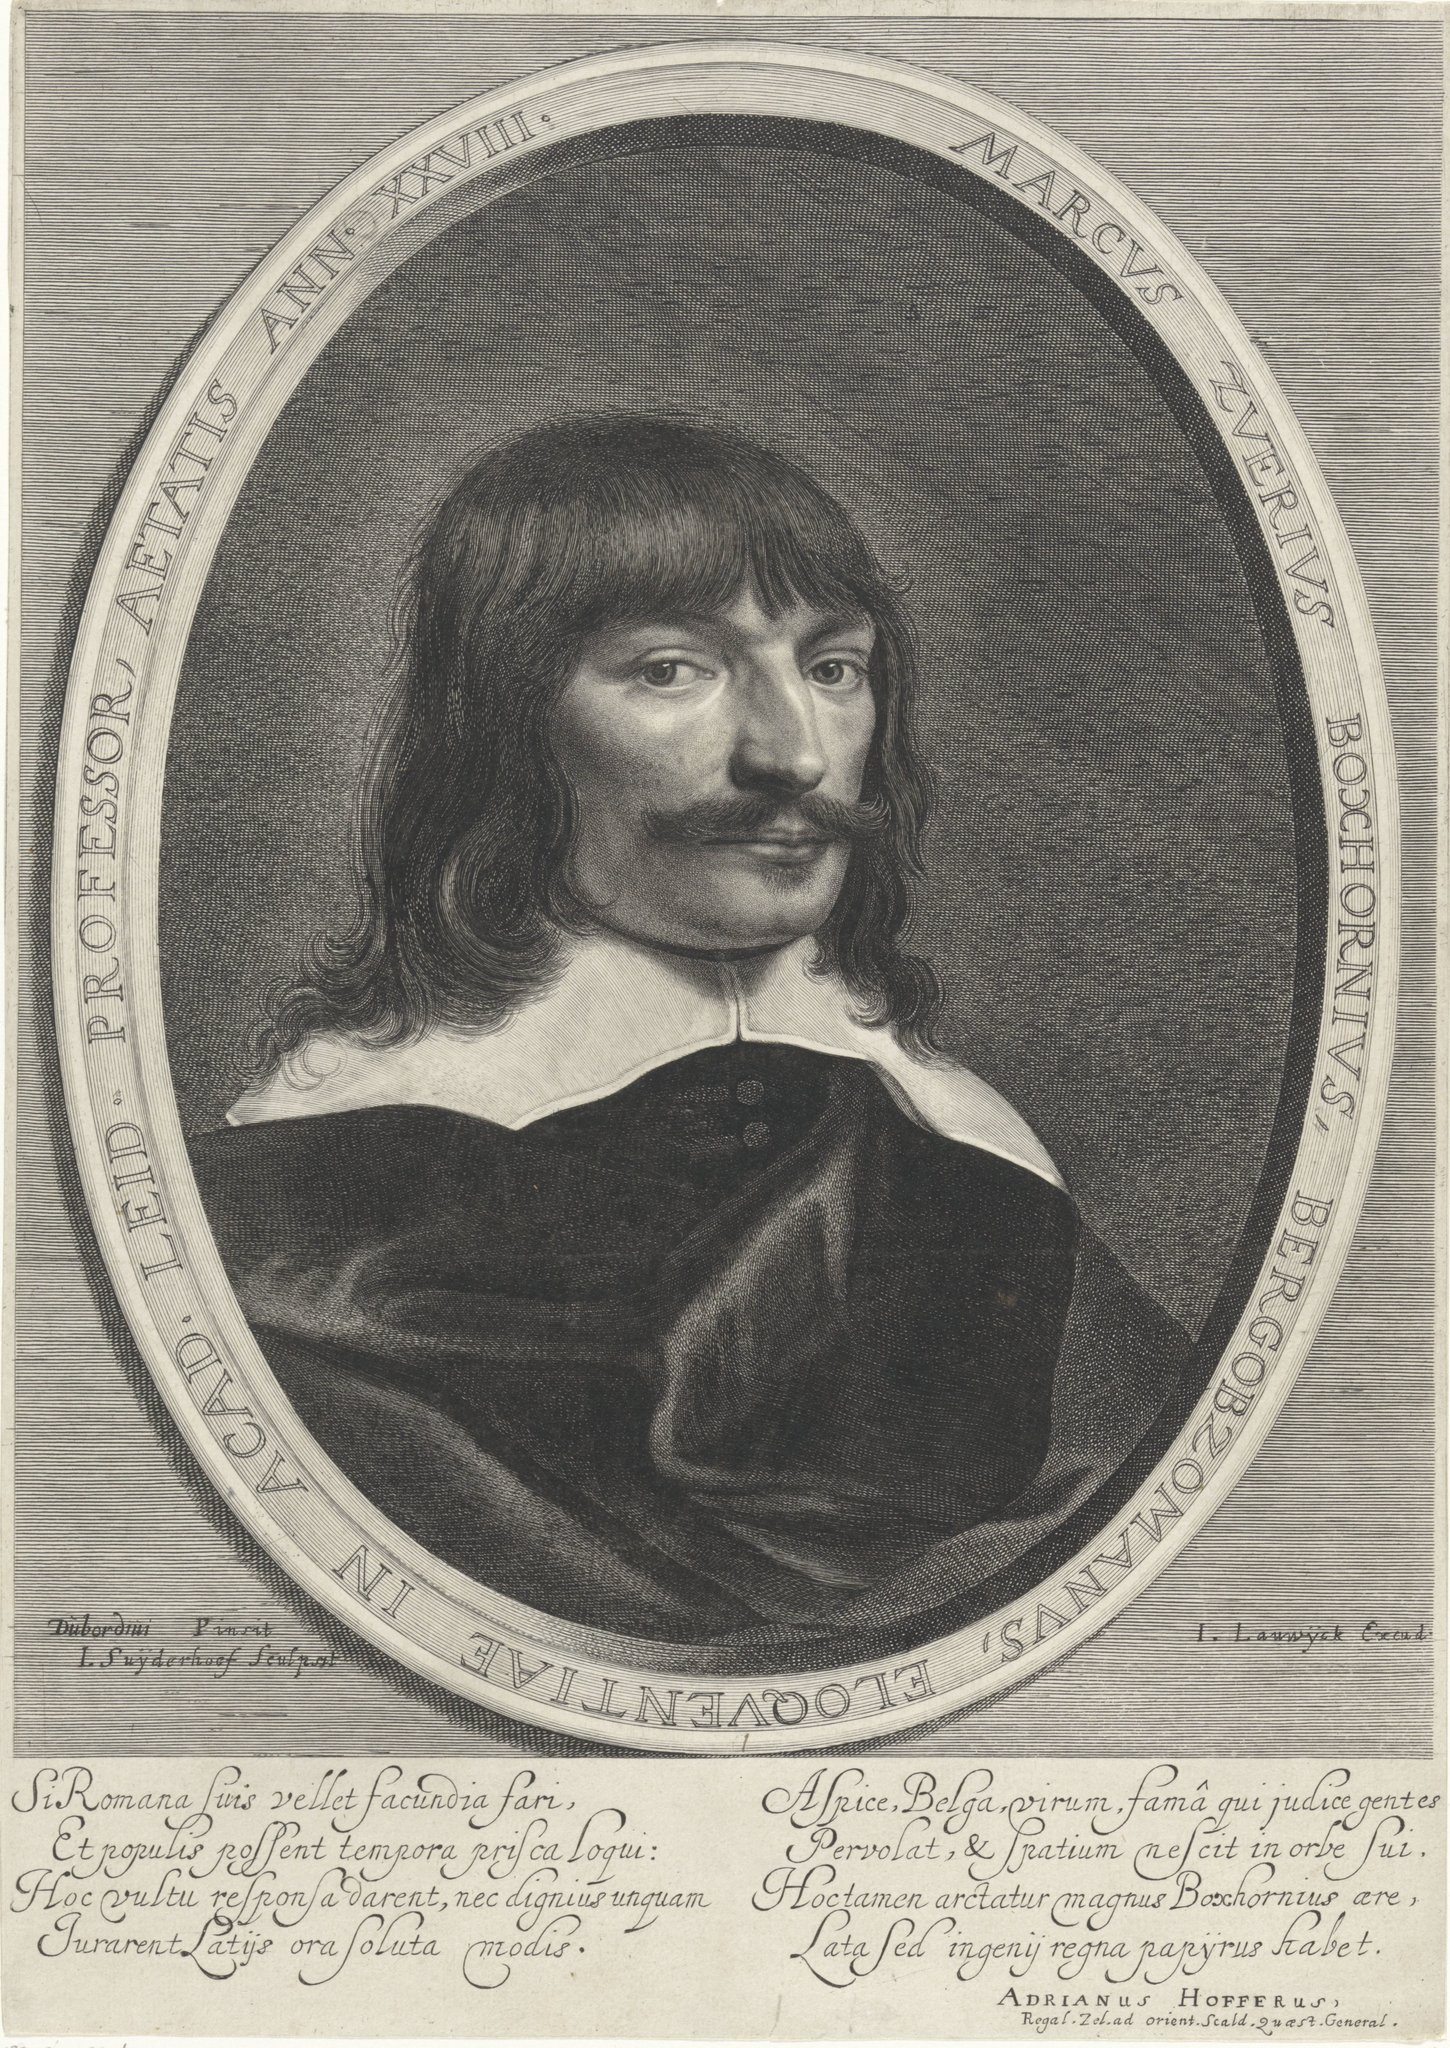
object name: print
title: Portret van Marcus Zuerius Boxhorn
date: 1640-1686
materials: paper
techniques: engraving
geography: leiden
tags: bergen op zoom, leiden, marcus zuerius boxhorn, historical disciplines; philology (+ portrait of scholar, scientist), professor (+ portrait of teacher, professor)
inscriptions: signature: ‘Dubordini Pinxit I. Suyderhoef sculpsit I. Lauwijck Excud.’, caption: ‘Si Romana suis vellet facundia fari, Et populis possent tempora prisca loqui: Hoc vultu responsa darent, nec dignius unquam Iurarent Latijs ora soluta modis. Alpice, Belga, virum, famâ qui judice gentes Pervolat, & Spatium nescit in orbe sui, Hoc tamen arctatur magnus Boxhornius are, Lata sed ingenij regna papyrus habet.’, signature: ‘Adrianus Hofferus, Regal. Zel. ad orient Scald. Quoest. General.’, edge inscription: ‘MARCUS ZUERIUS BOXHORNIUS, BERGOBZOMANUS, ELOQUENTIAE IN ACAD. LEID. PROFESSOR, AETATIS ANN. XXVIII.’, collector's mark: Lugt 240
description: Portret van Marcus Zuerius Boxhorn, hoogleraar welsprekendheid aan de universiteit van Leiden, op 28-jarige leeftijd. Onder het portret een achtregelig vers in het Latijn.